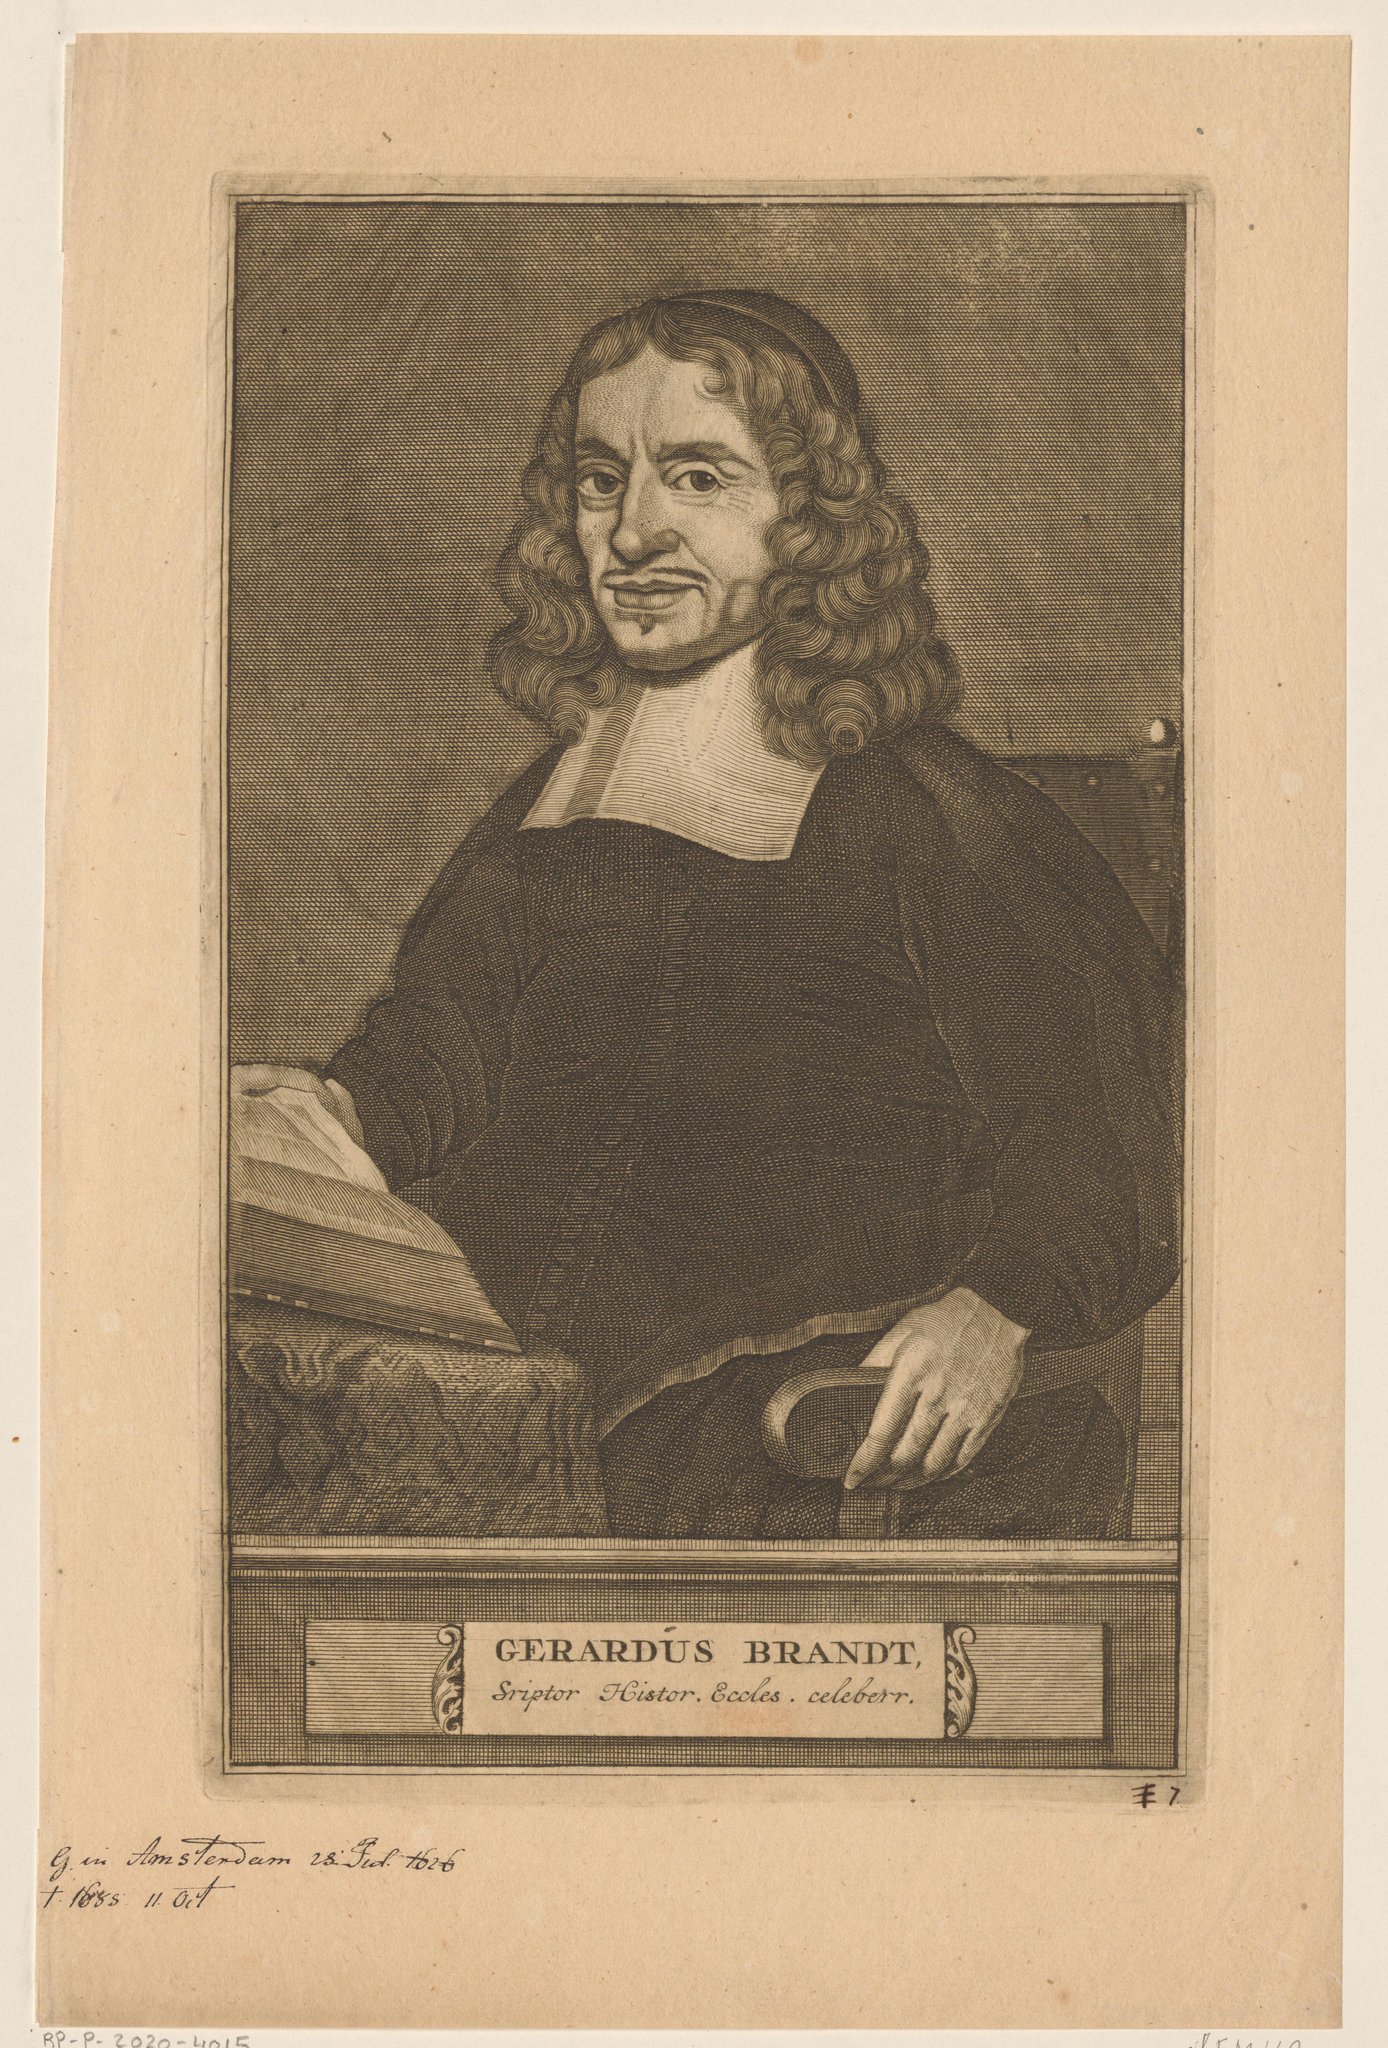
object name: print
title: Portret van Geeraert Brandt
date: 1687-1690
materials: paper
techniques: engraving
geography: leiden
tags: amsterdam, geeraert brandt (i), historical persons, book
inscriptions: inscription: ‘G. in Amsterdam (...)’